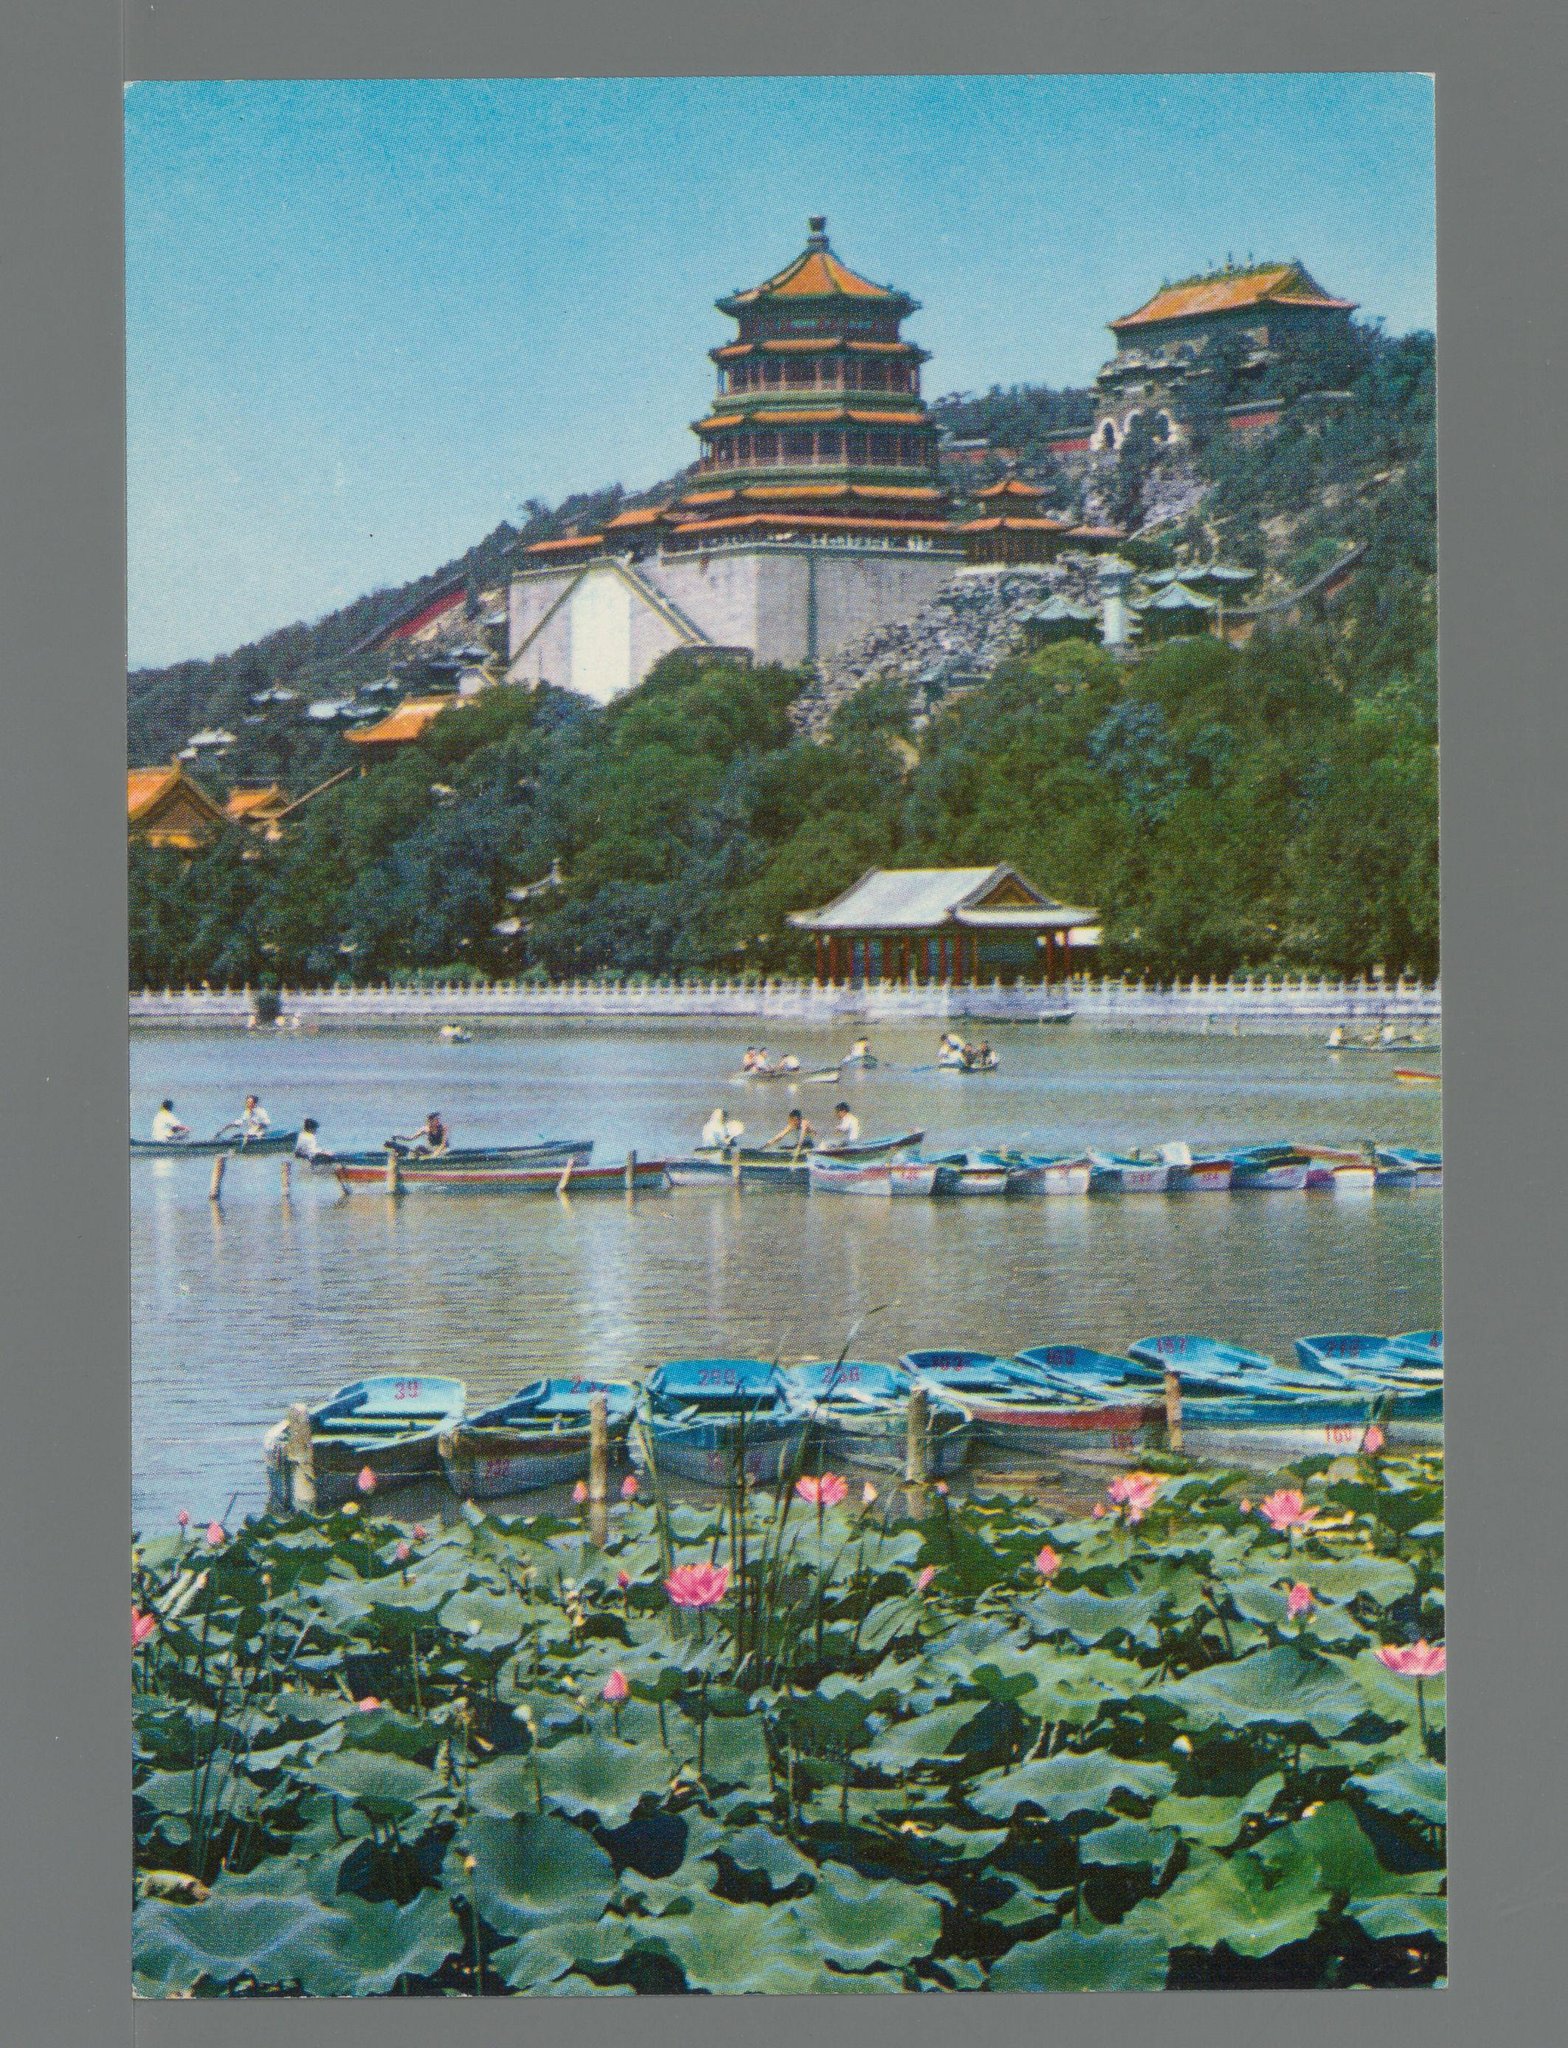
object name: photomechanical print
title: The Summer Palace, Peking / Vues du Palais d'Eté de Pékin / Vista del Palacio de Verano, Pekin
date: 1974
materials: cardboard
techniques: offset printed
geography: china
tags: palace, lake